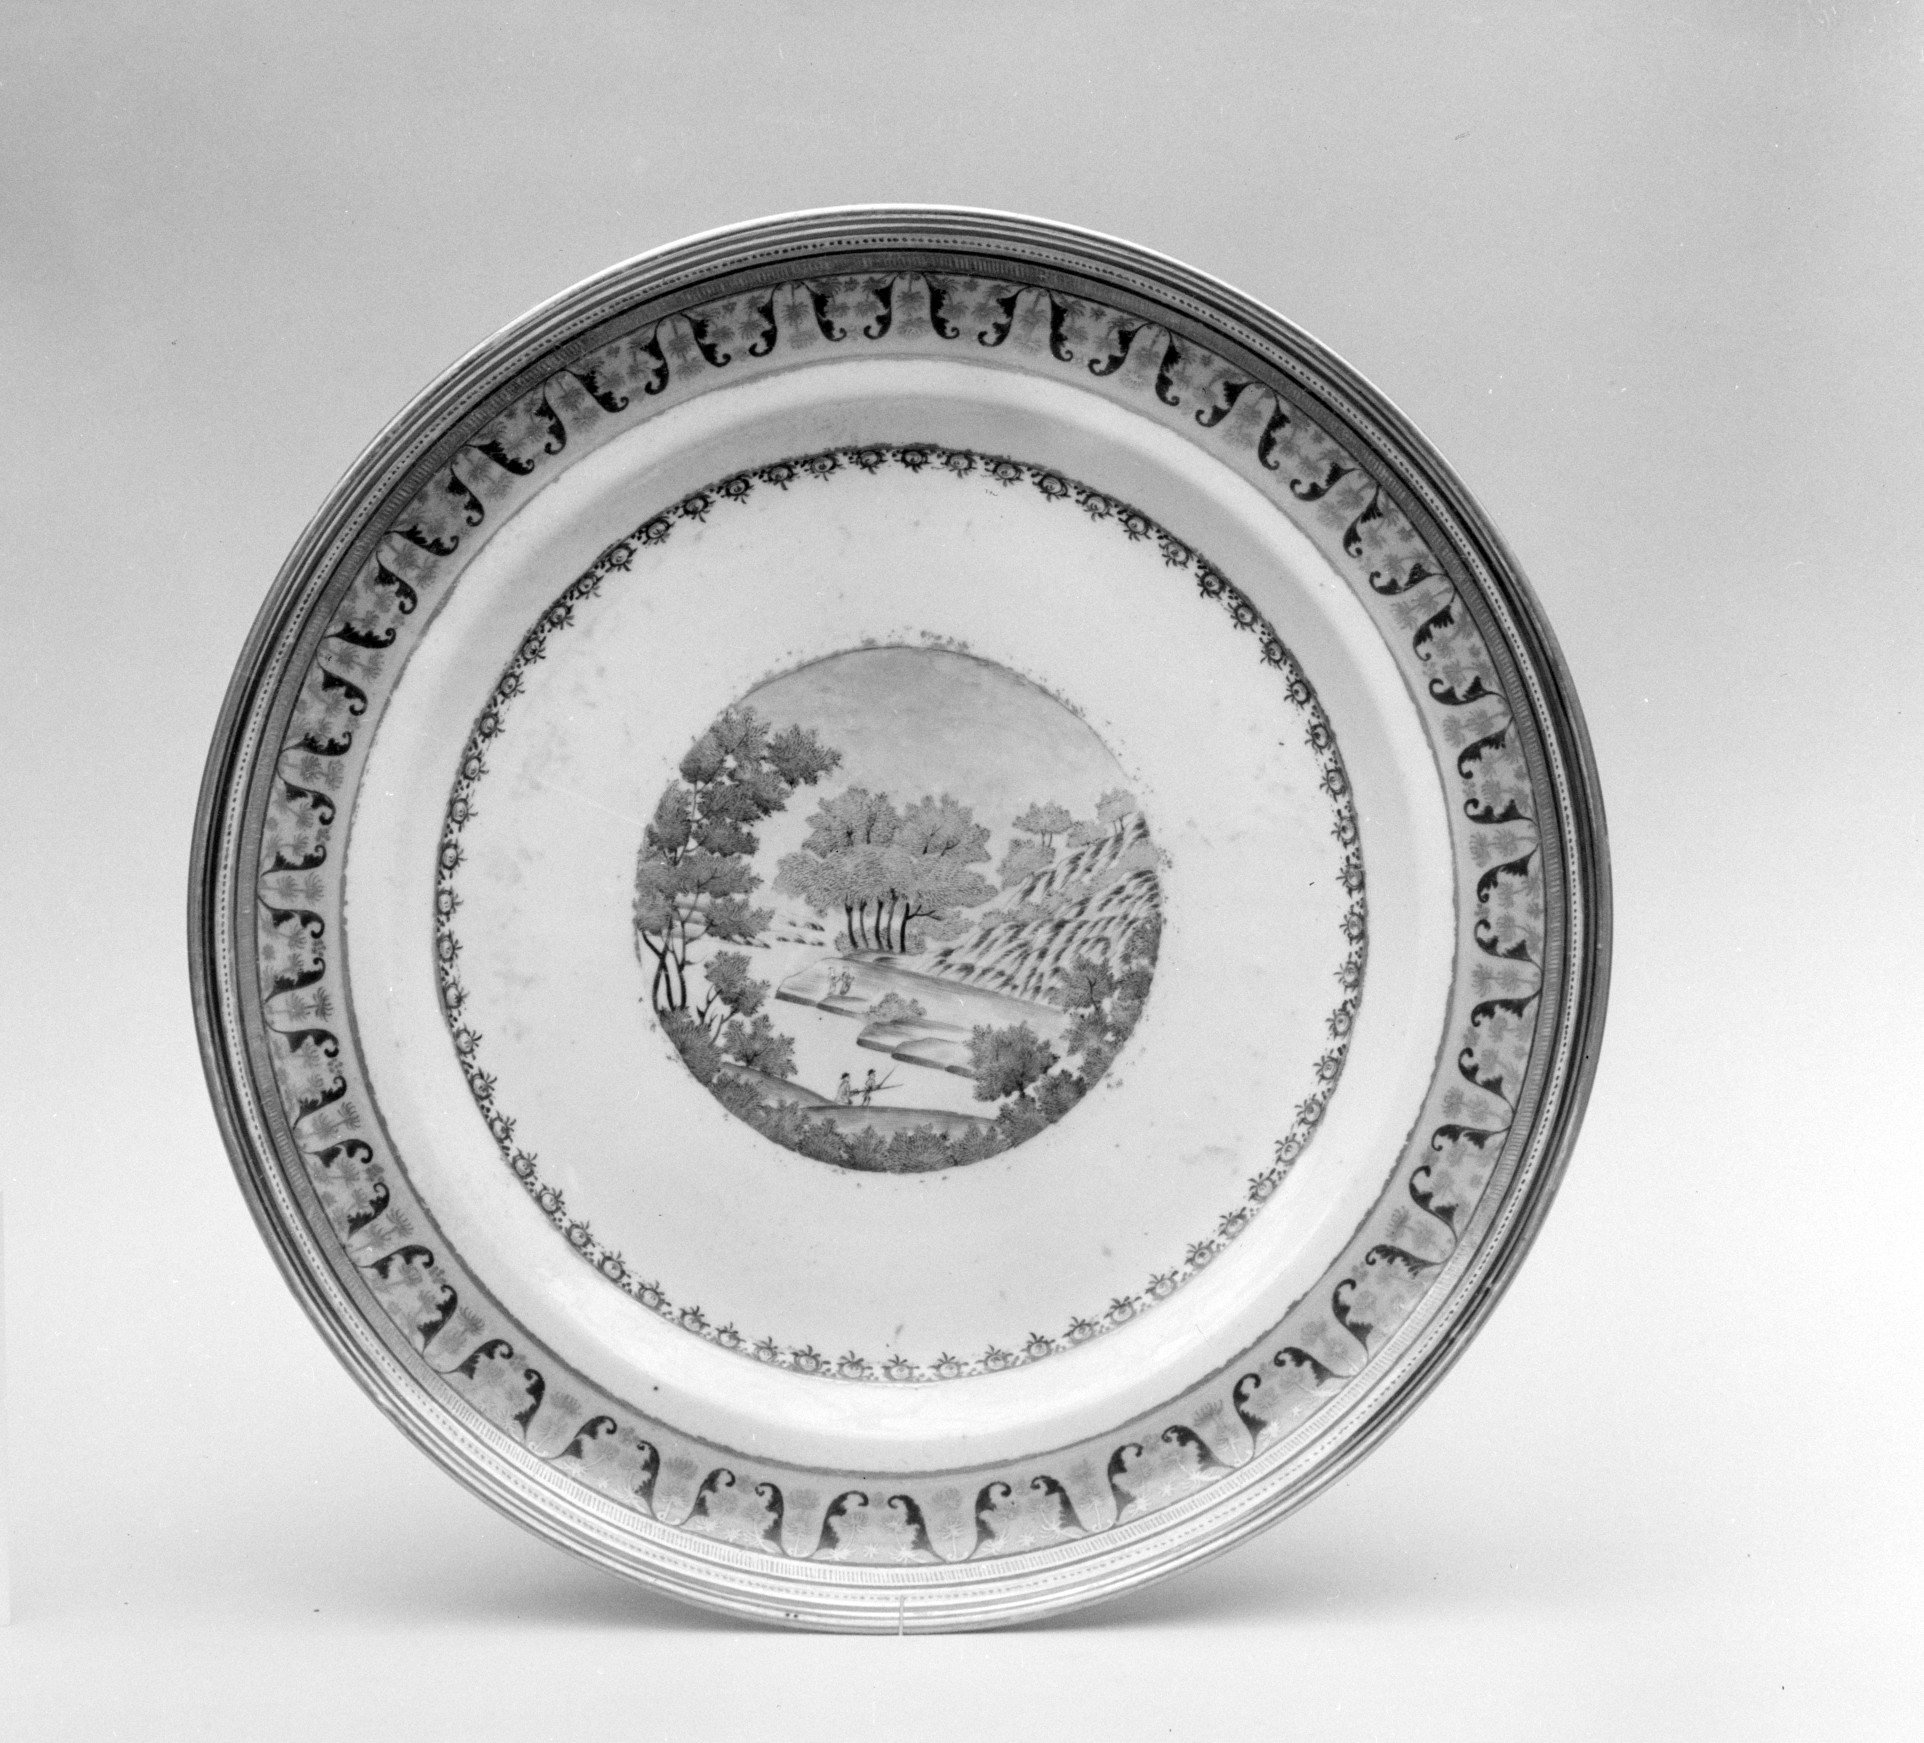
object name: plate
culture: chinese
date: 1800-1830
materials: porcelain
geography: china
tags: landscapes